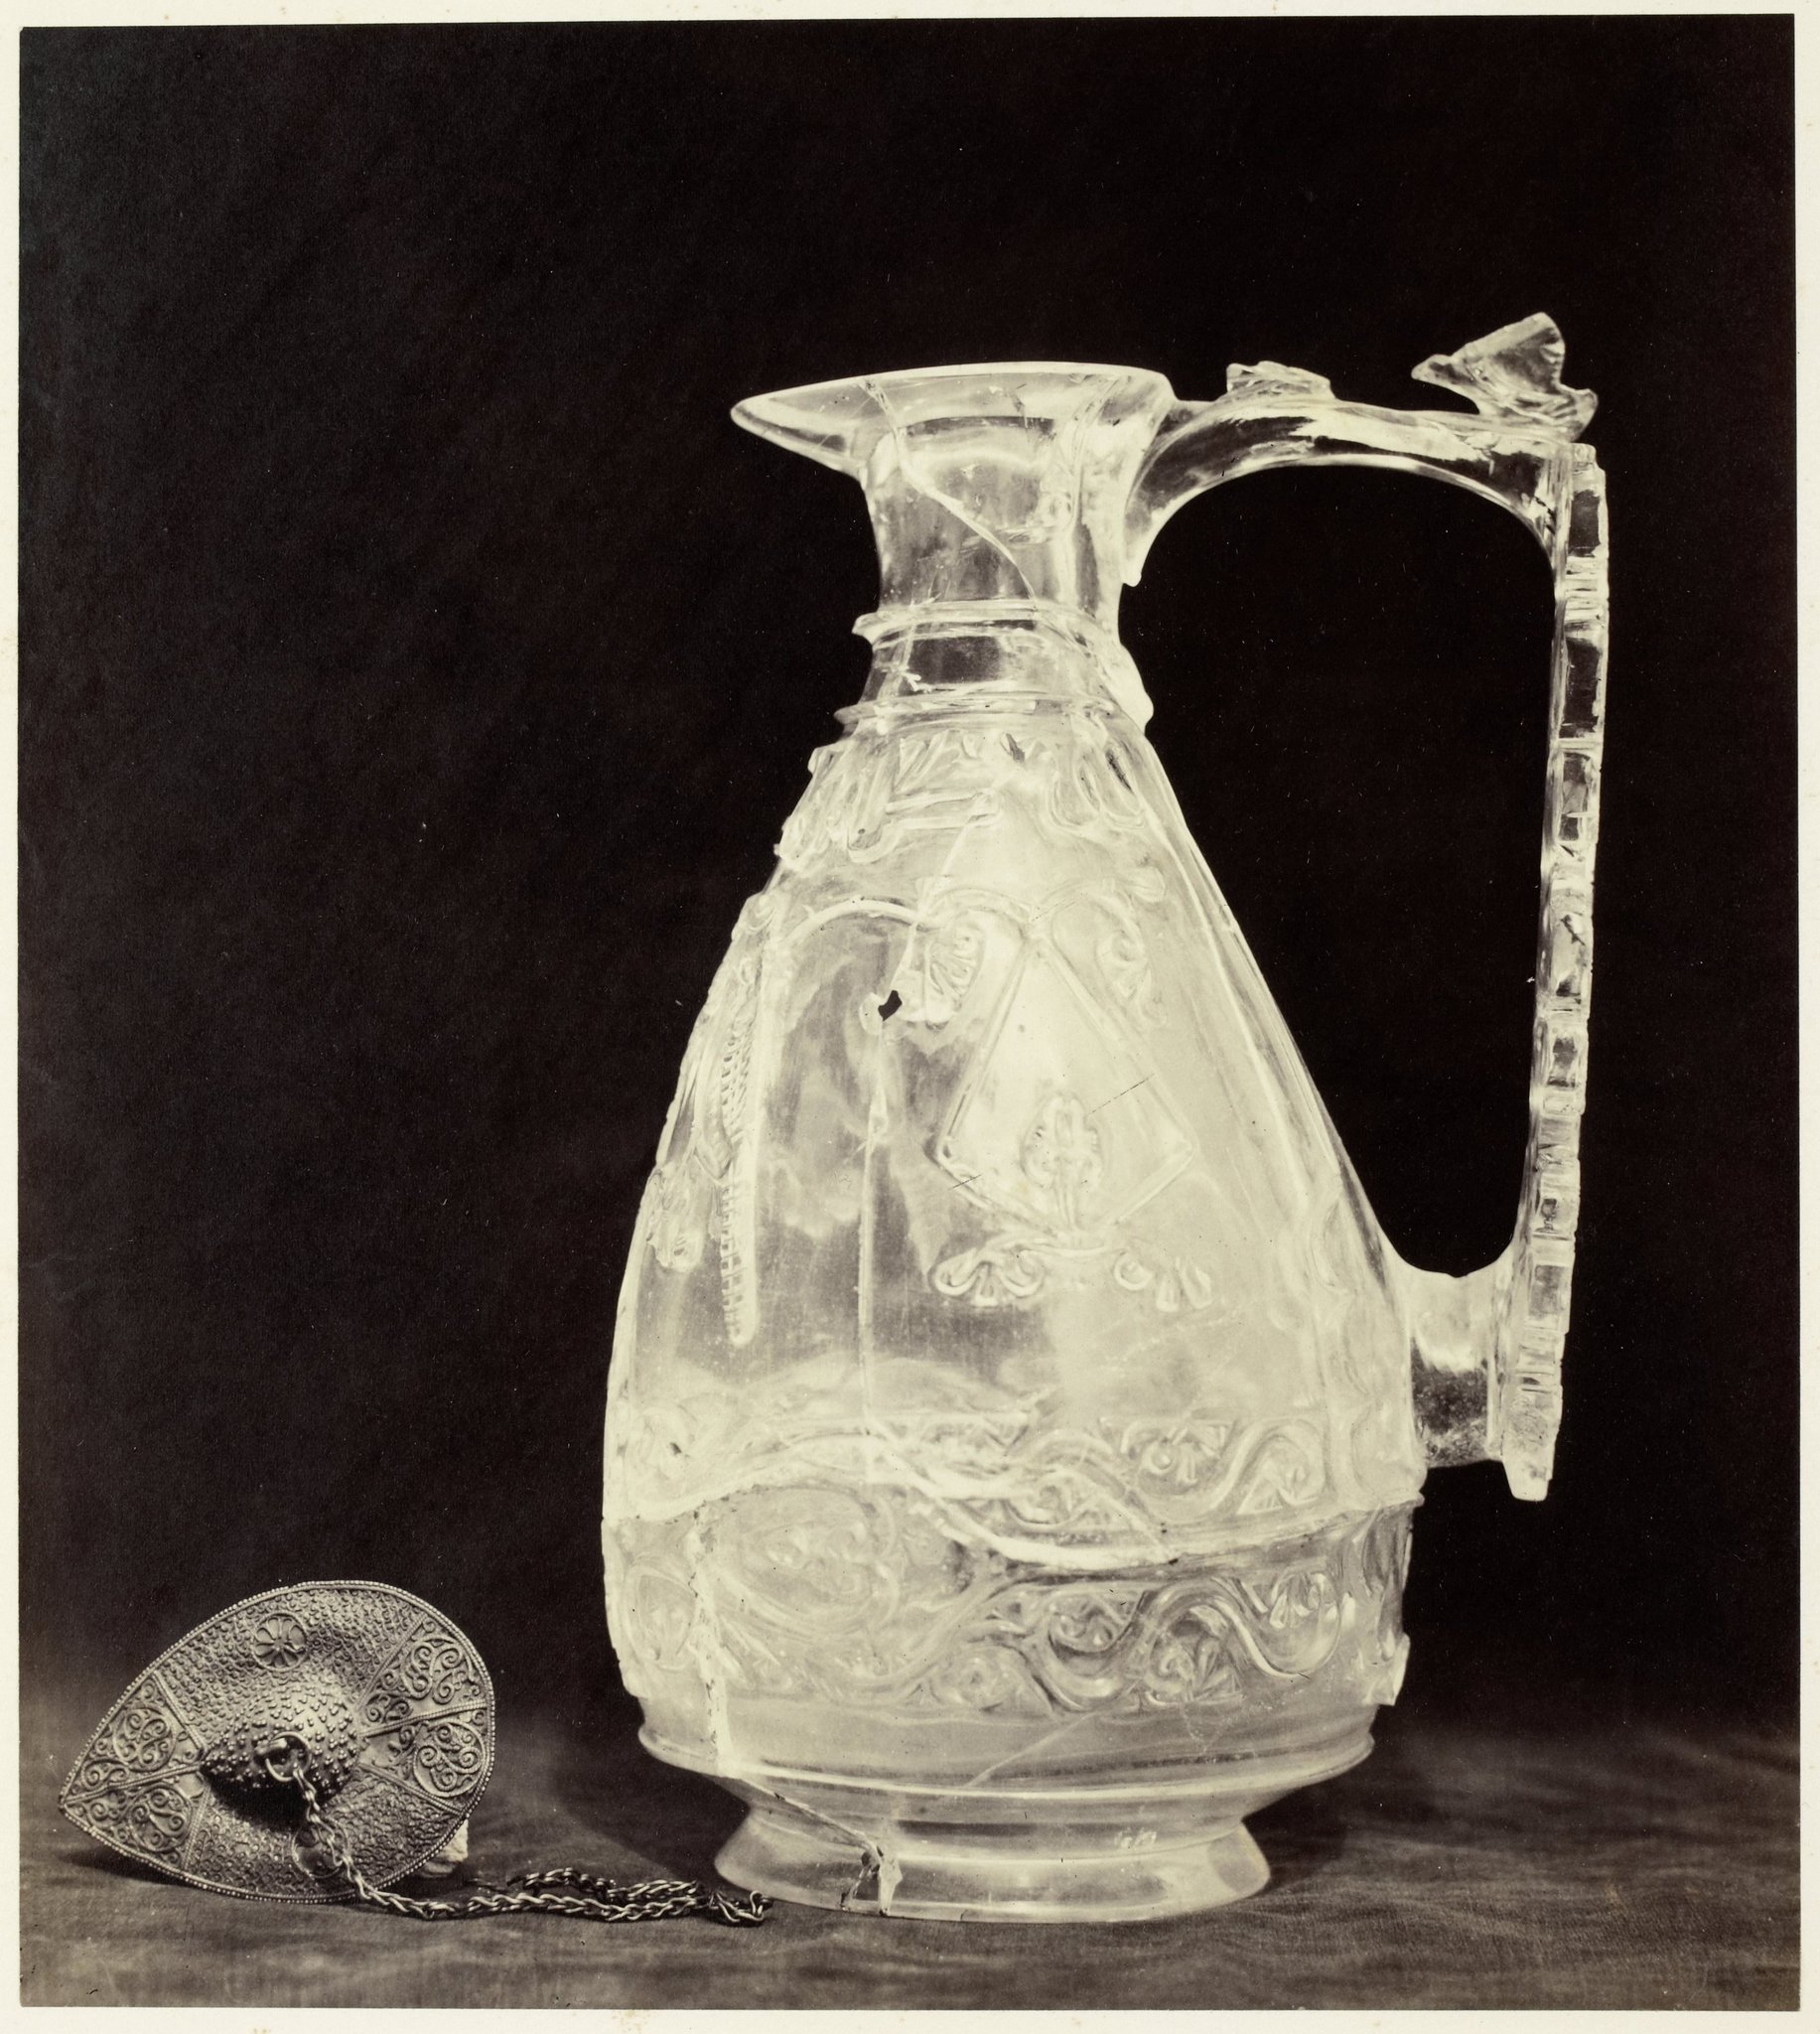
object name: photomechanical print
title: Kristallen kan met metalen stop, uit het Louvre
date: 1866-1890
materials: paper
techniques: woodburytype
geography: louvre museum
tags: container of glass: bottle, jar, vase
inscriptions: inscription: ‘Photographed by C. Thurston Thompson.’